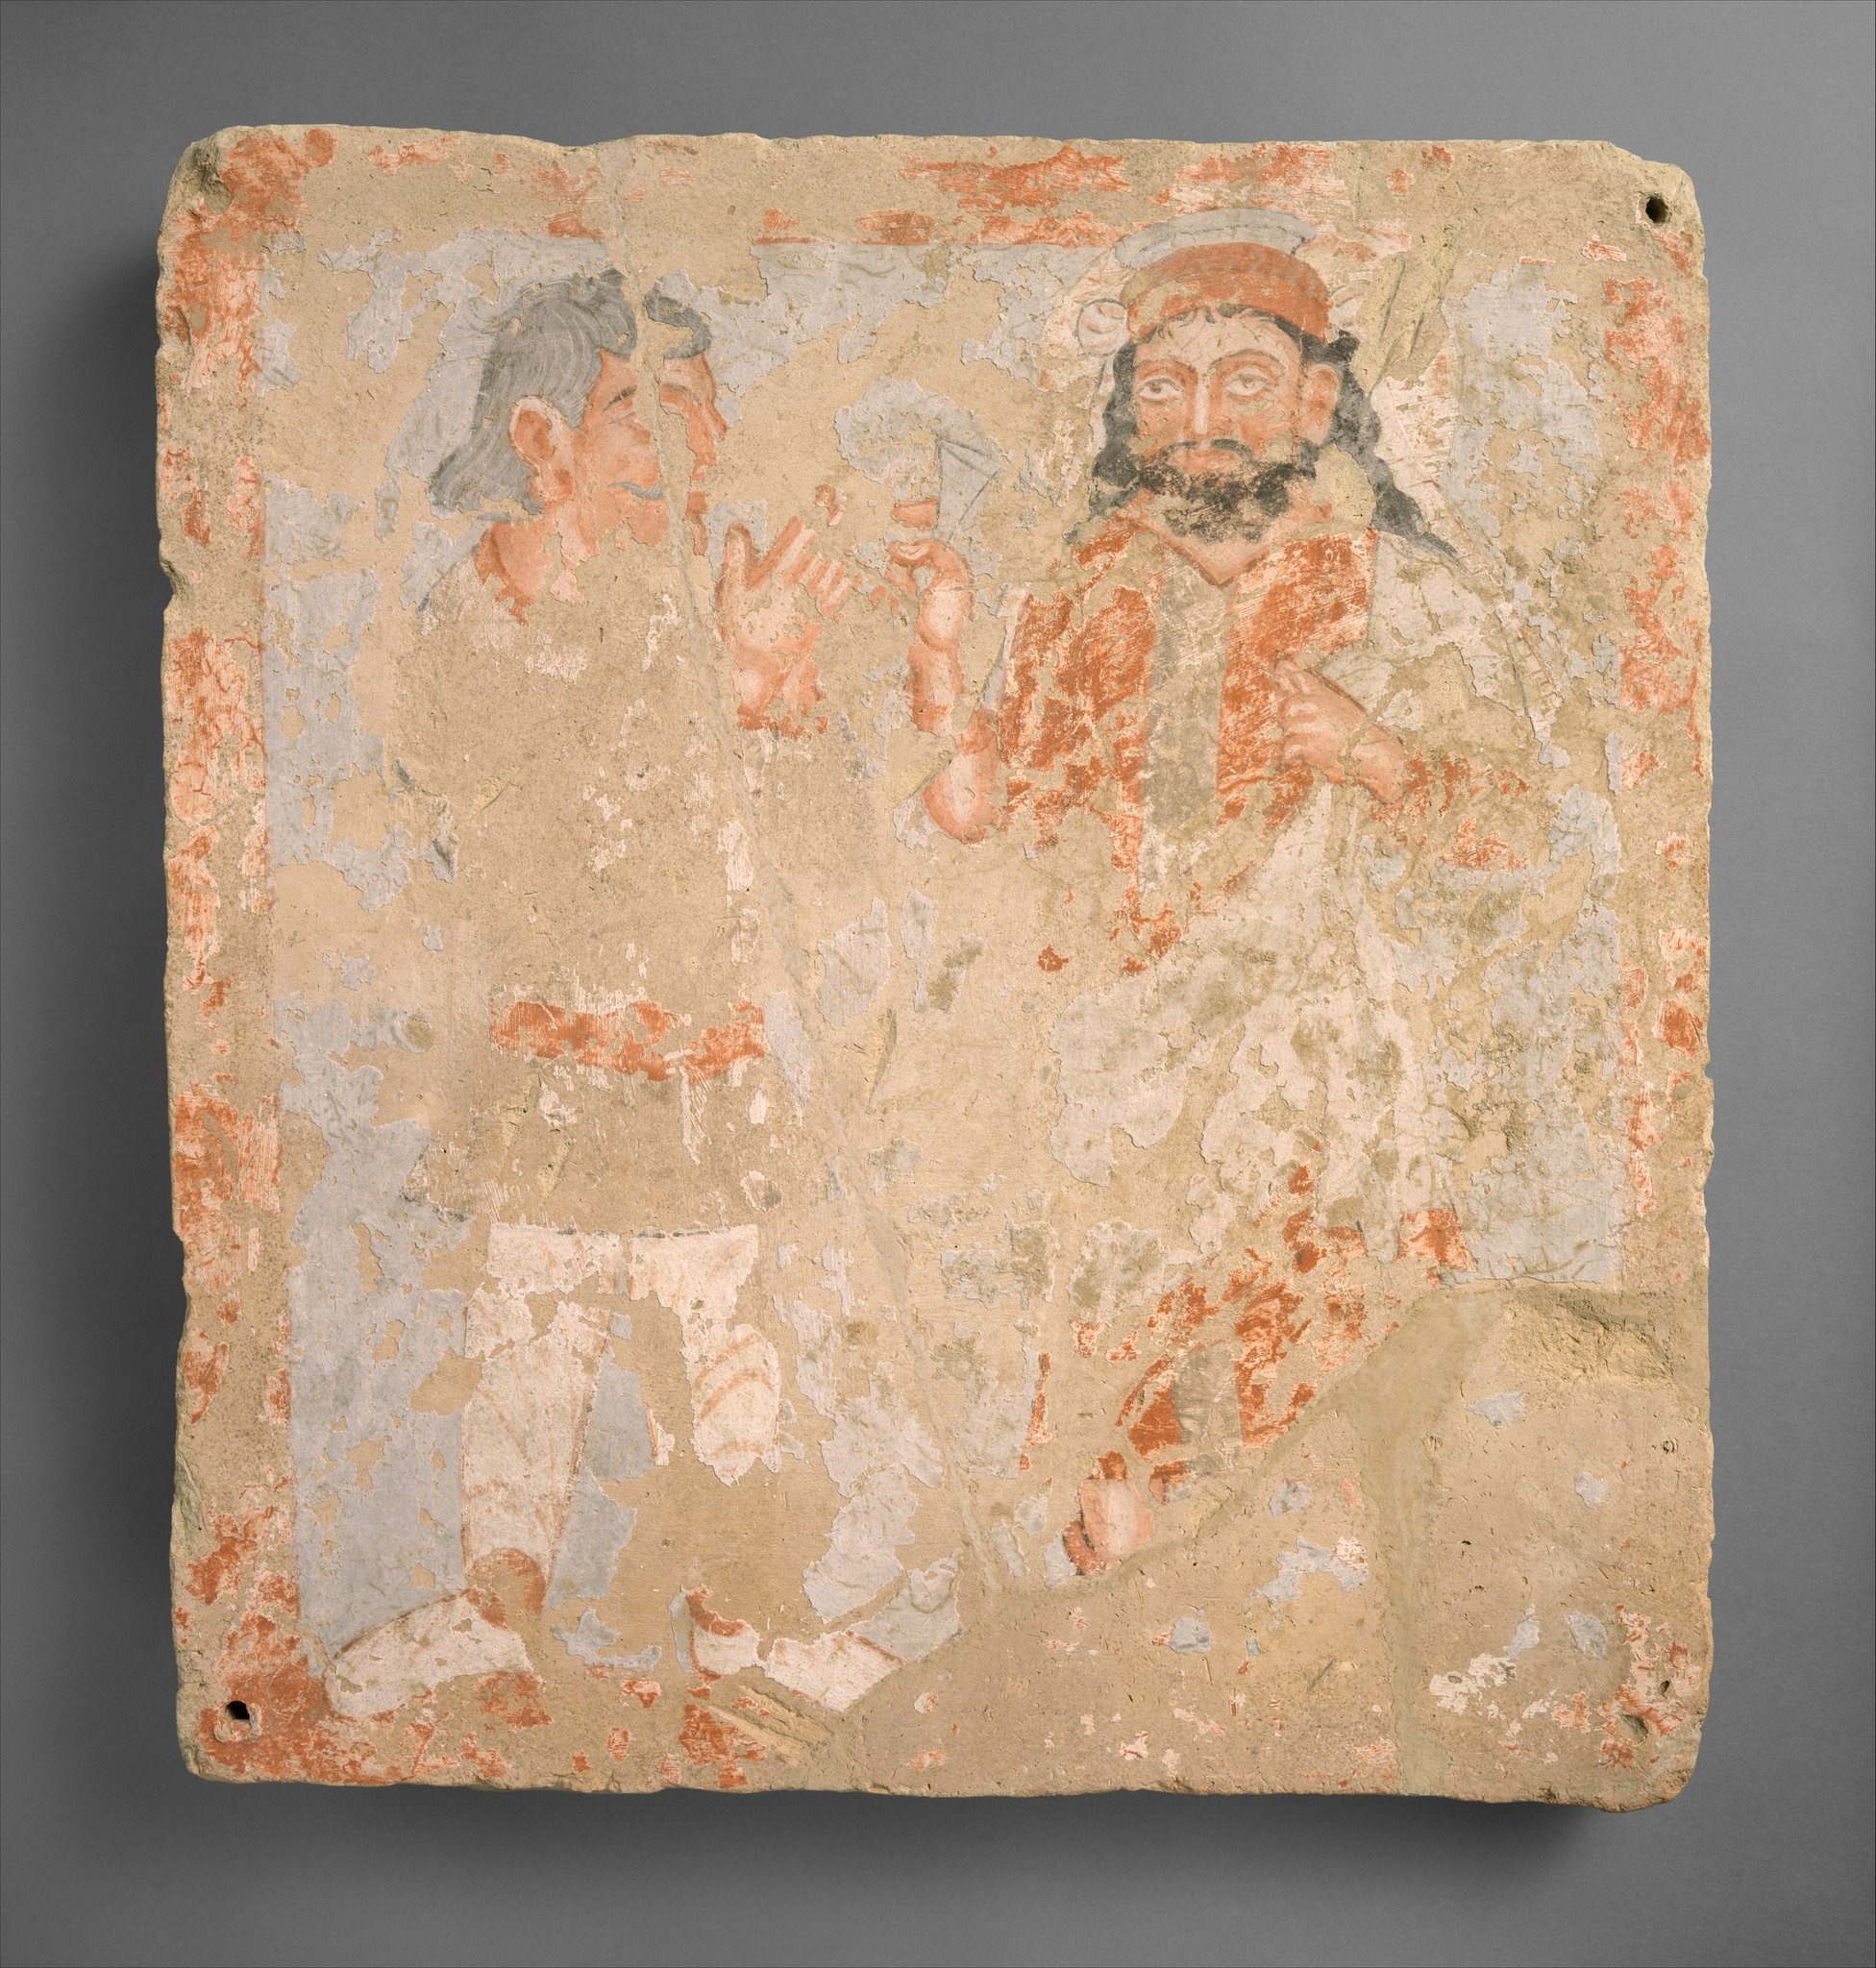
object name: painted panel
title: Panel with the god Zeus/Serapis/Ohrmazd and worshiper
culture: kushan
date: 201-300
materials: gouache, terracotta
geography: northern afghanistan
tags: men,zeus